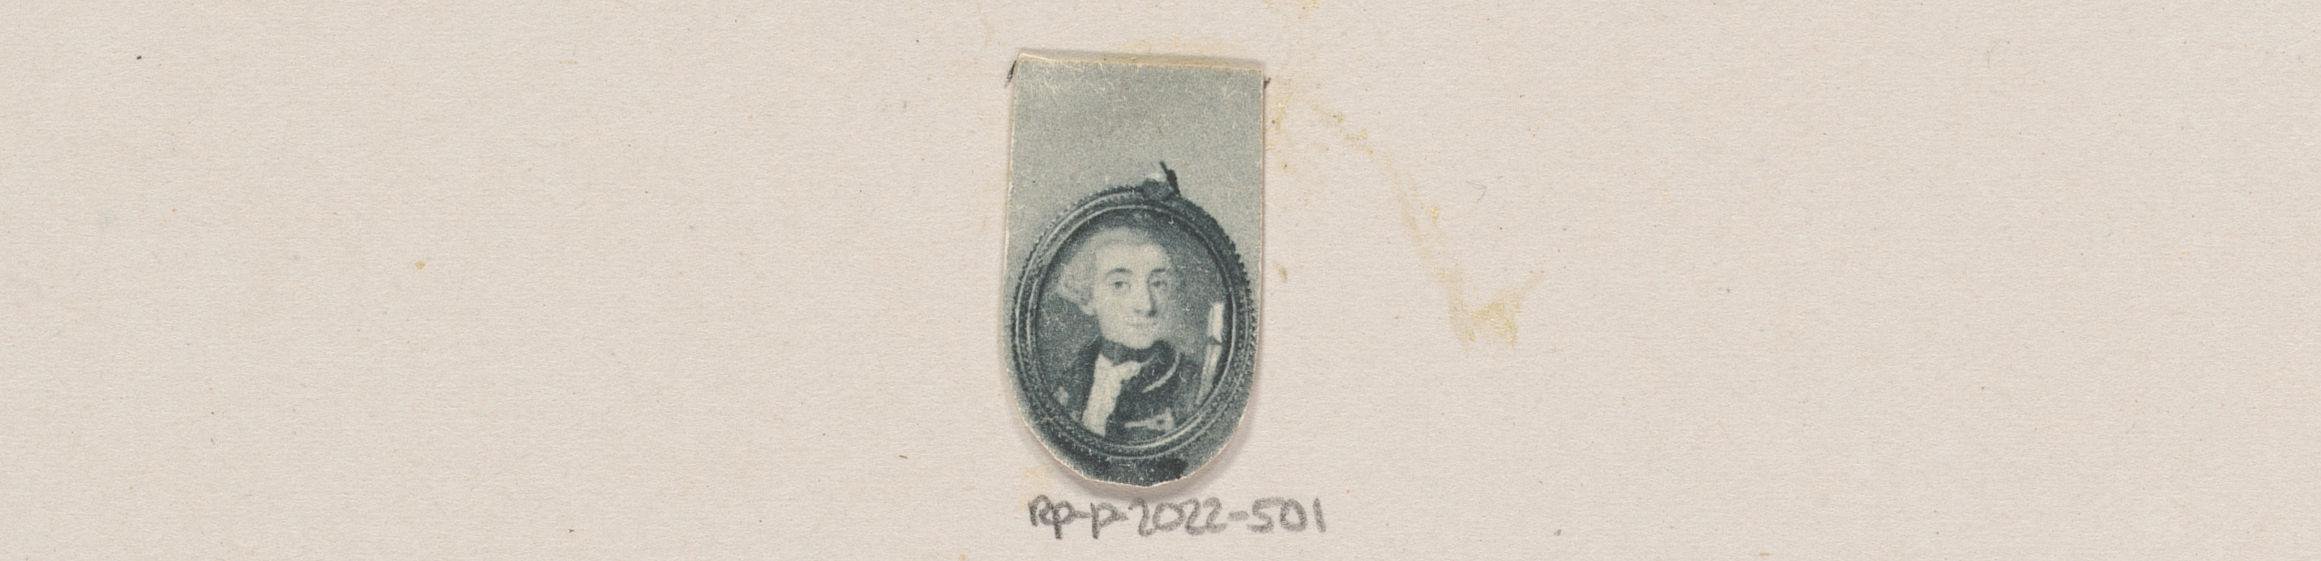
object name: photomechanical print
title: Portret van Moses Mendelssohn in medaillon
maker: Anonymous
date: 1875-1930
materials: paper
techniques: photograph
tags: berlin, historical persons